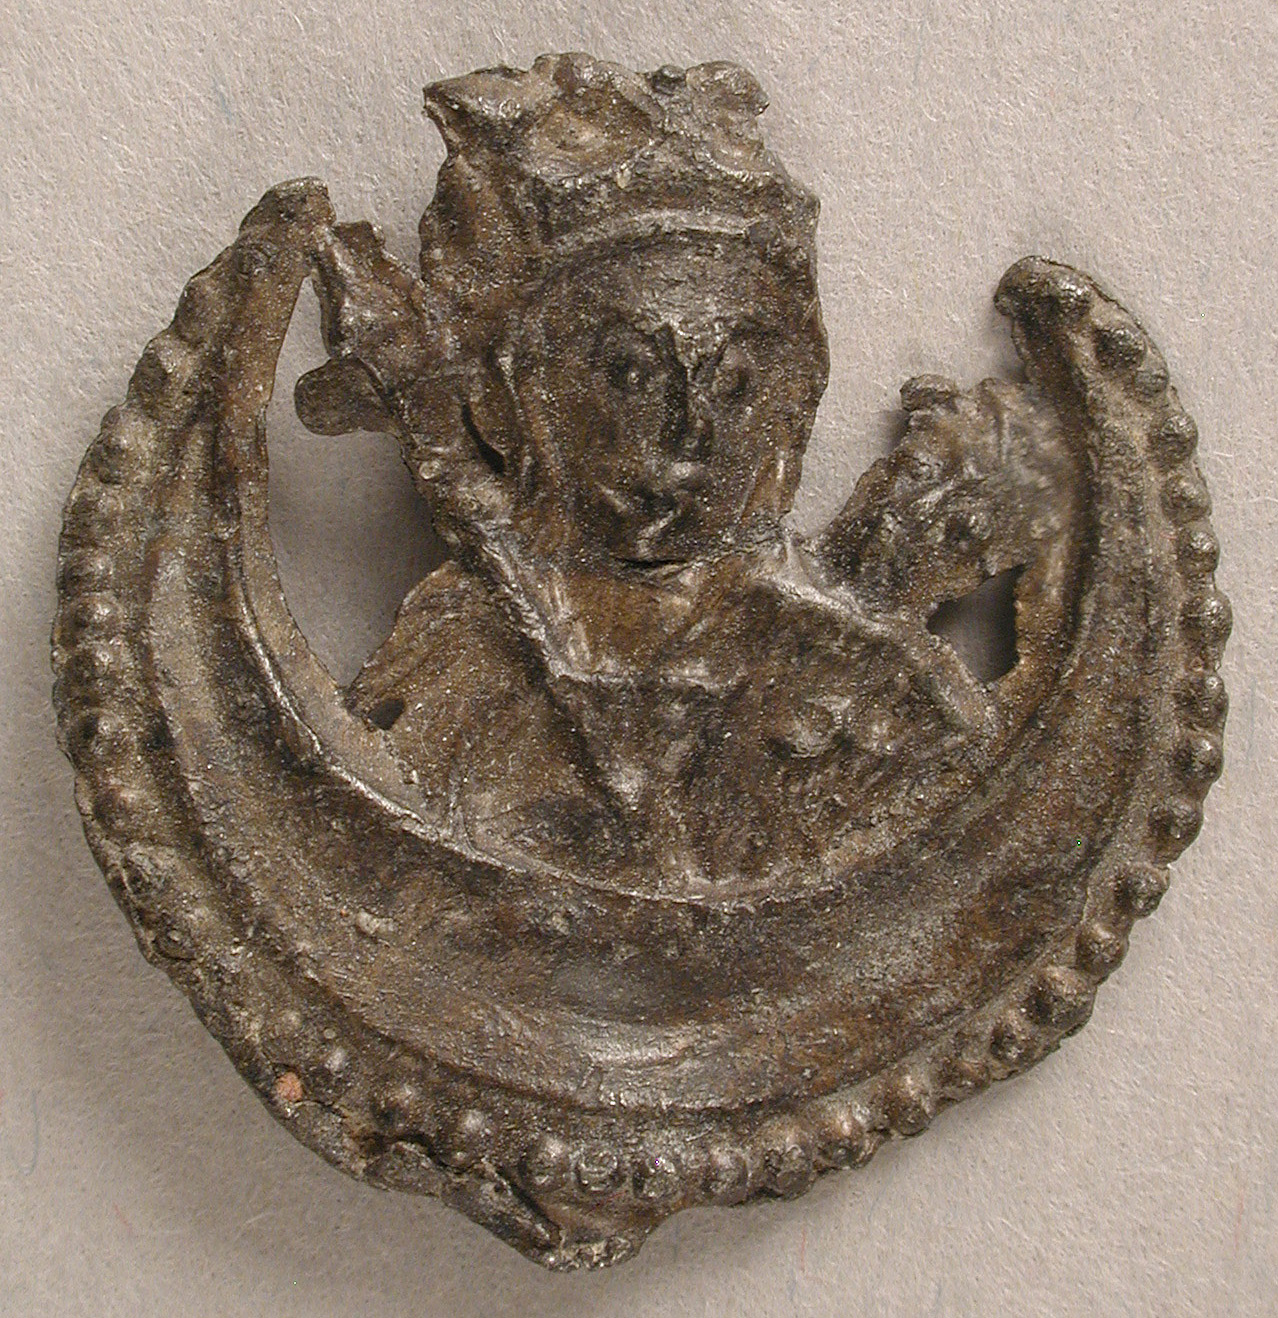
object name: pilgrim's badge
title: Badge with Madonna and Infant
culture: british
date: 1467-1533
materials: alloy, lead, tin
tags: madonna and child